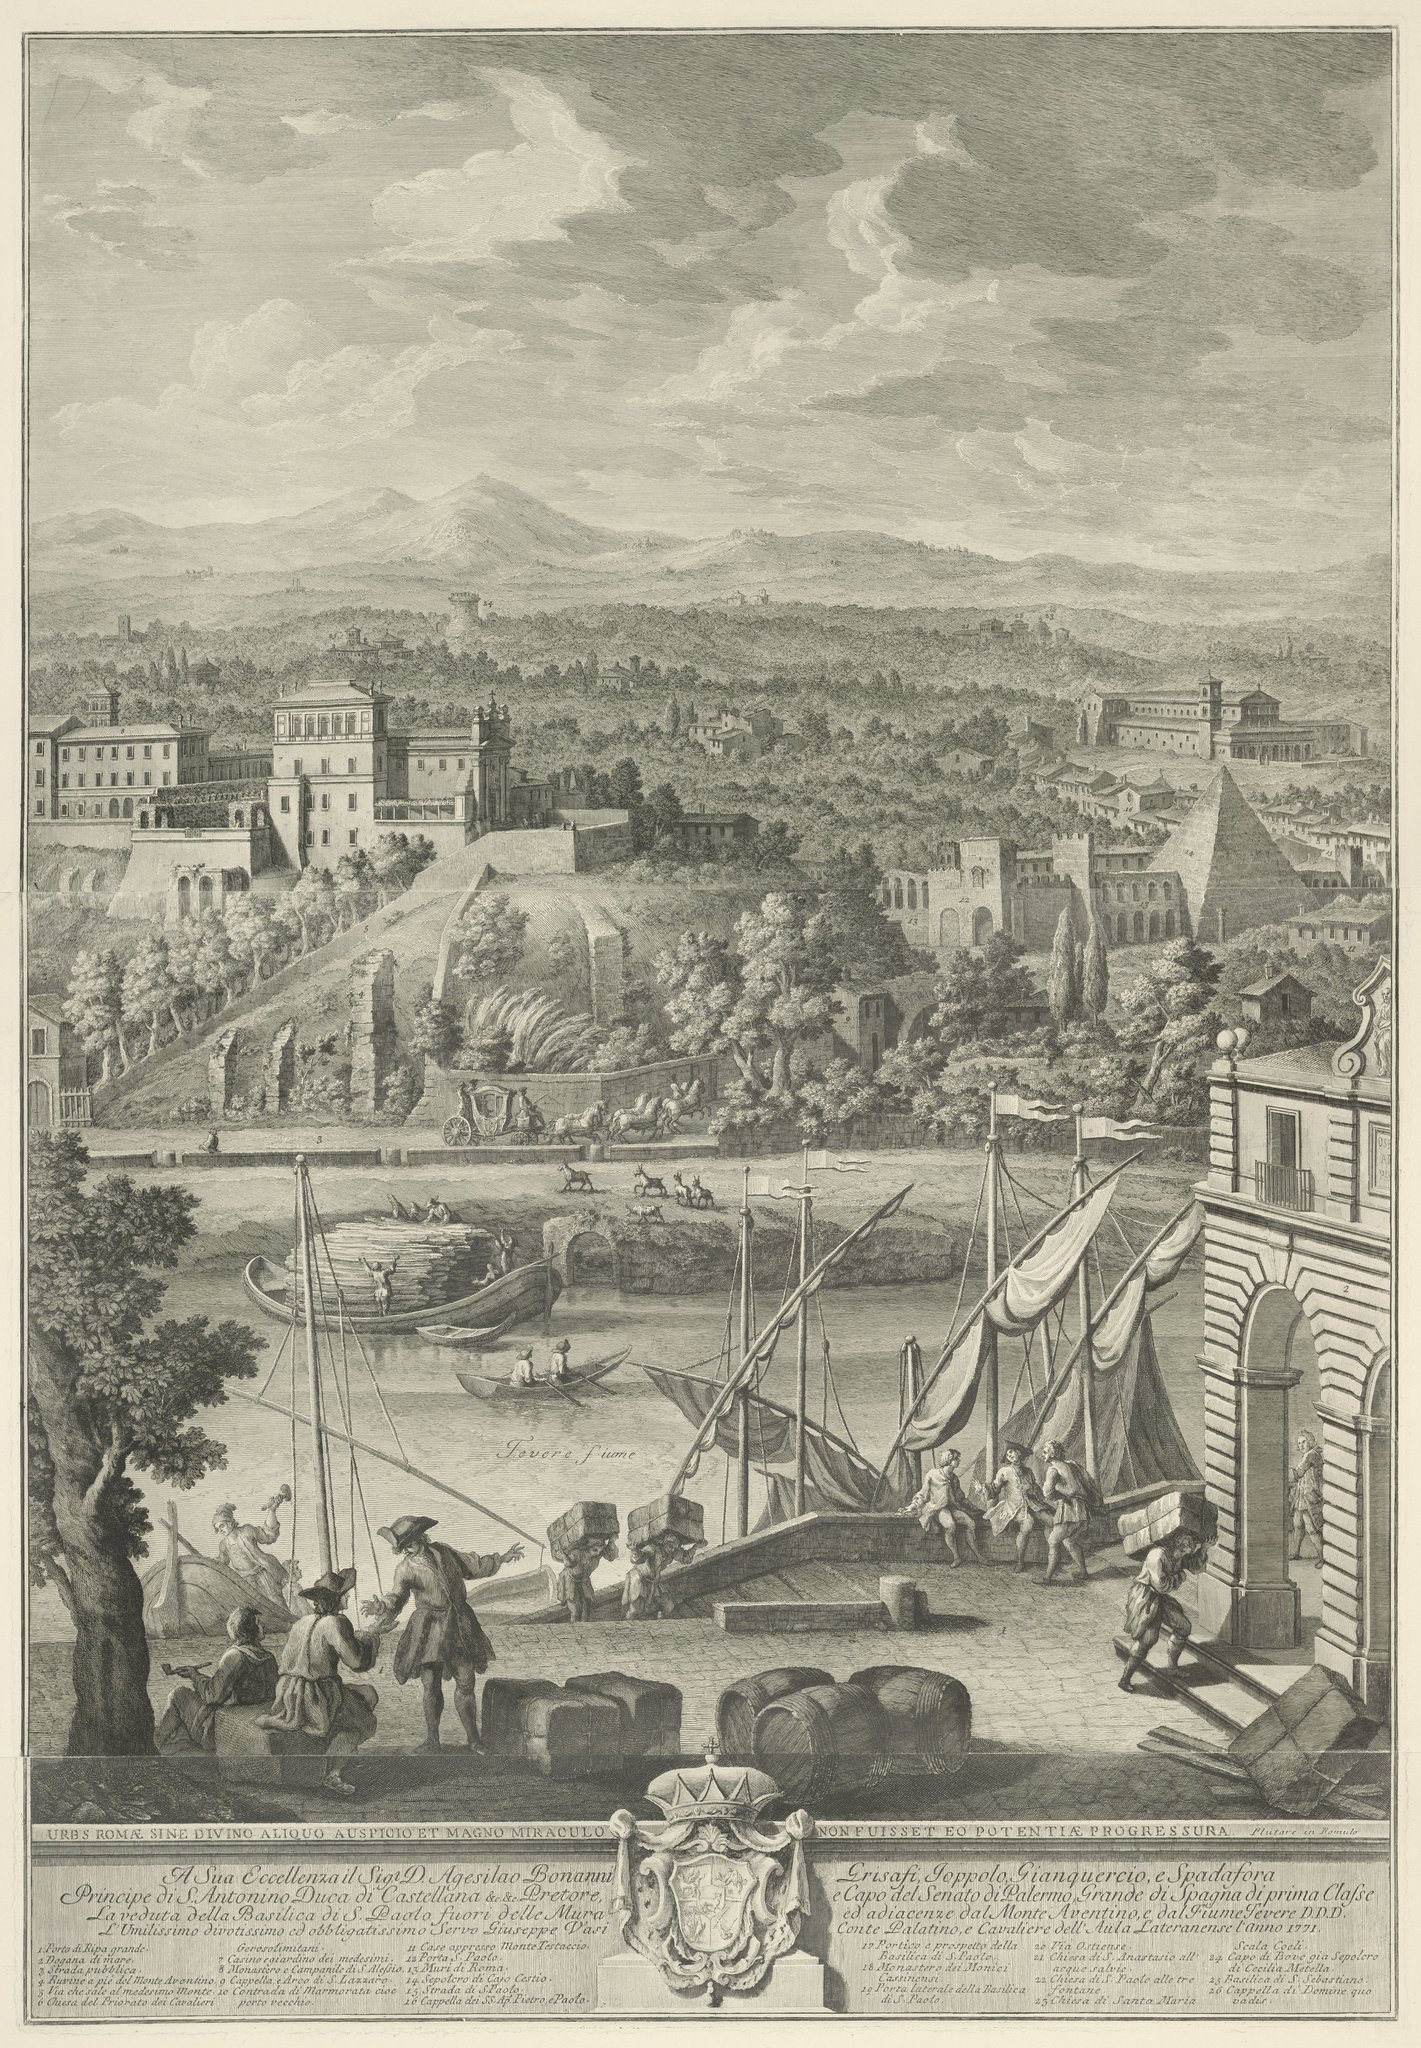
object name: print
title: Urbs Romae sine divino aliquo auspicio et magno miraculo non fuisset eo potentiae progressura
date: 1771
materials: paper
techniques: etching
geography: rome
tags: city-view in general; 'veduta', rome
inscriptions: collector's mark: Lugt 2228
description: Gezicht op de Tiber en Aventijn heuvel te Rome. Verklarende lijst met nummers en wapenschild in ondermarge.